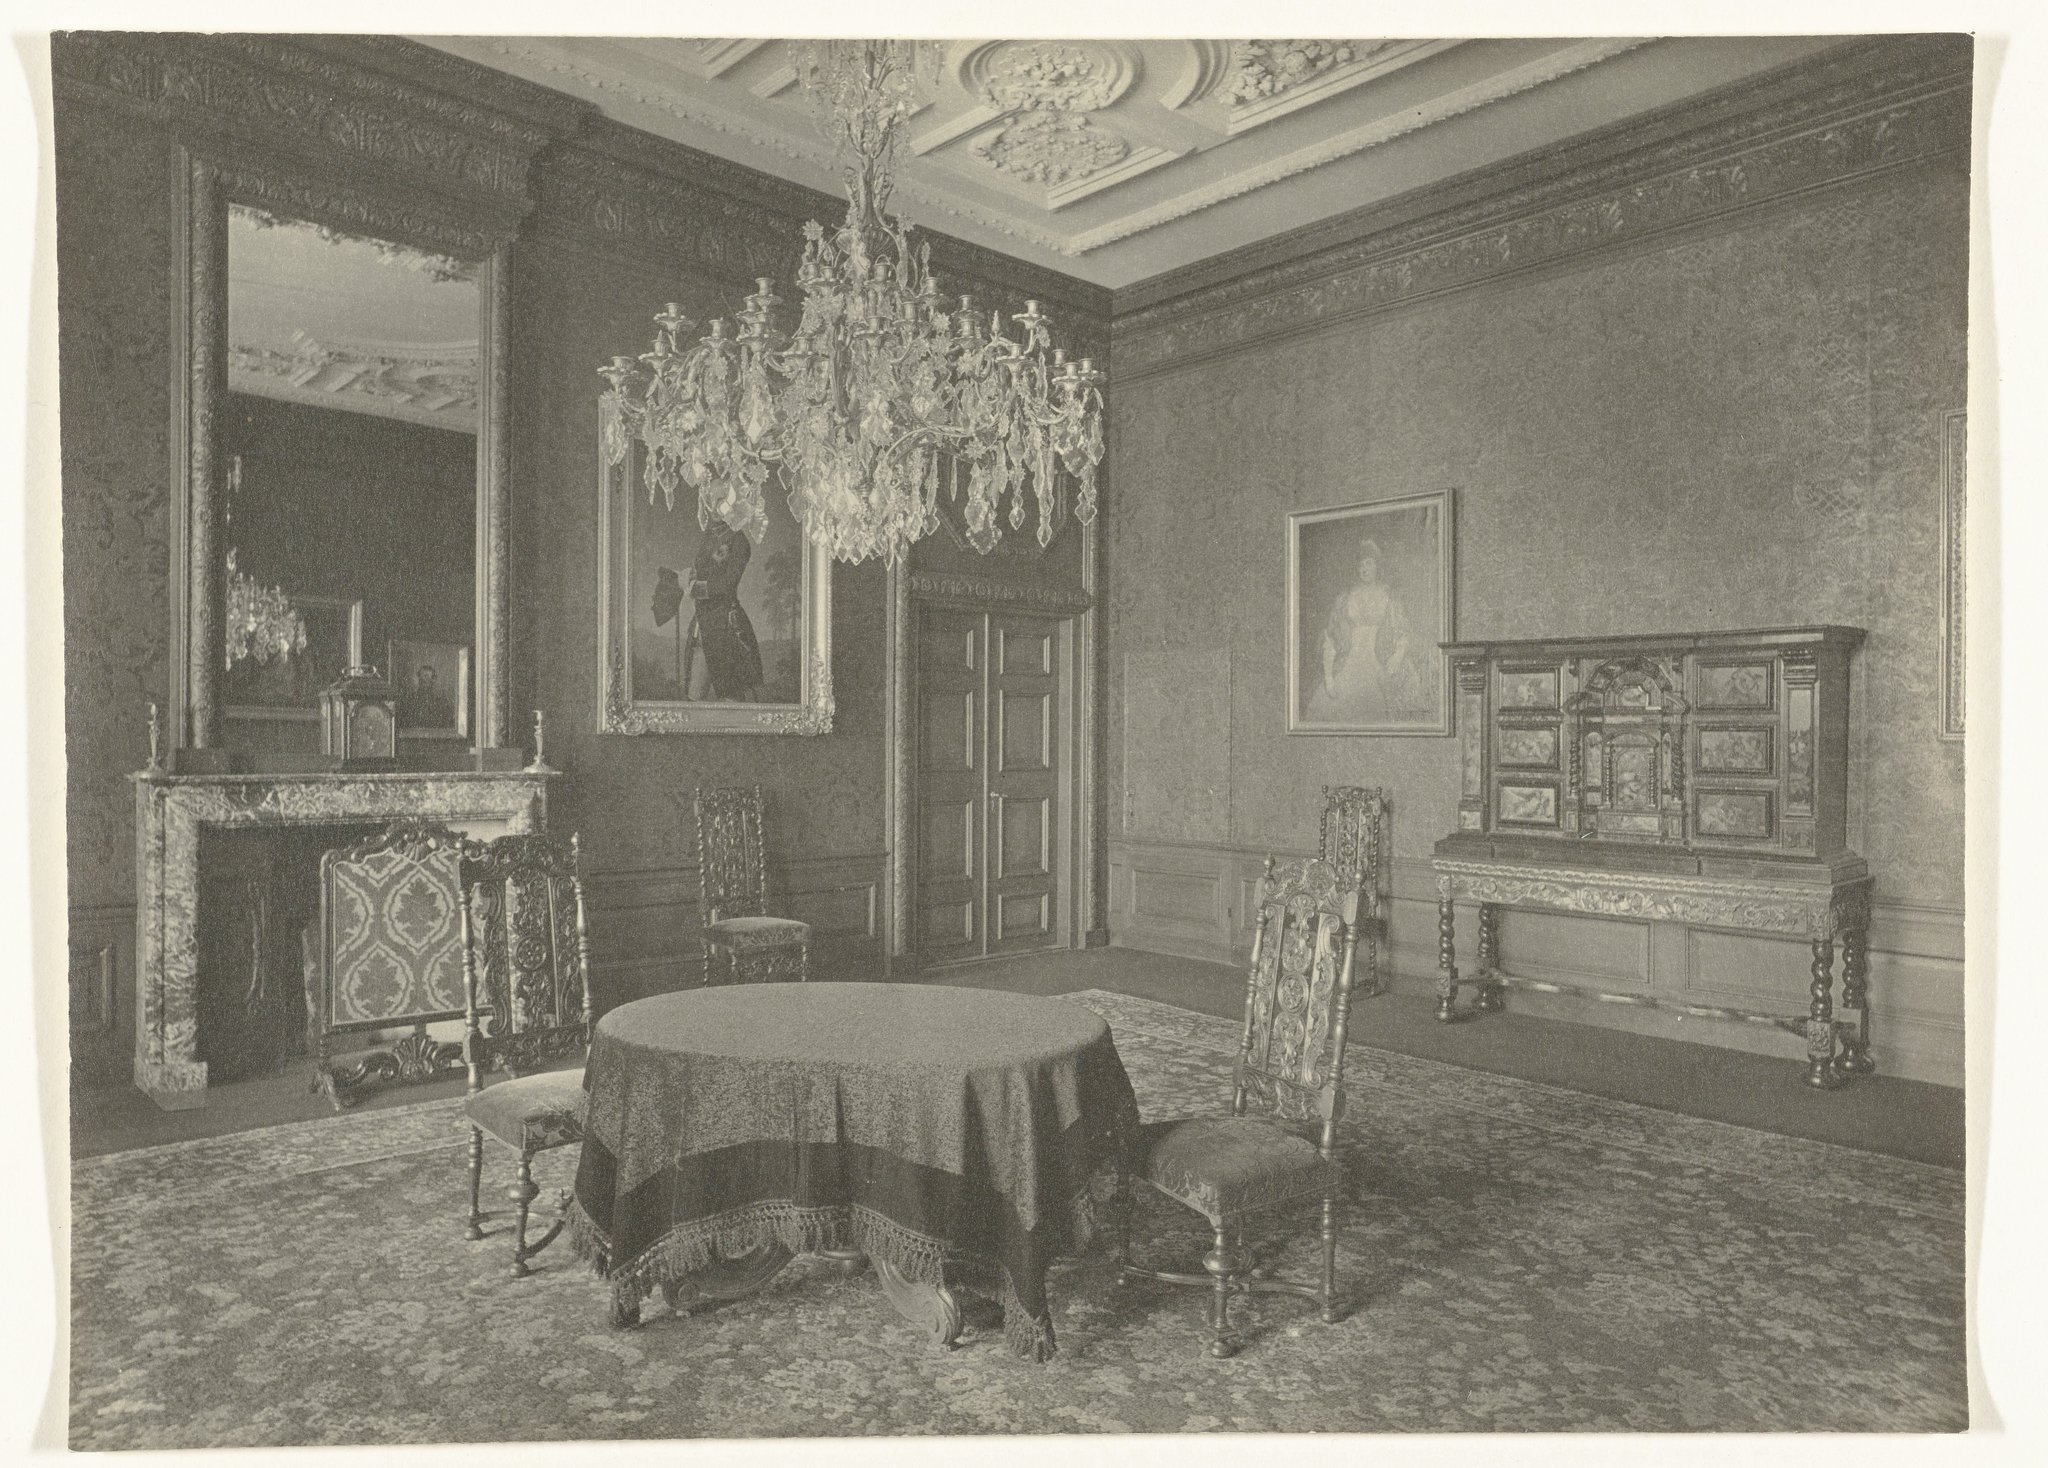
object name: photograph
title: Gezicht in de antichambre van Paleis Het Loo in Apeldoorn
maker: richard tepe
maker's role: fotograaf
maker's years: 1864-1952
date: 1900-1930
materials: paper, photographic support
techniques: gelatin silver print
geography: netherlands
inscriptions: signature: ‘foto / R Tepe’, annotation: ‘Antichambre’